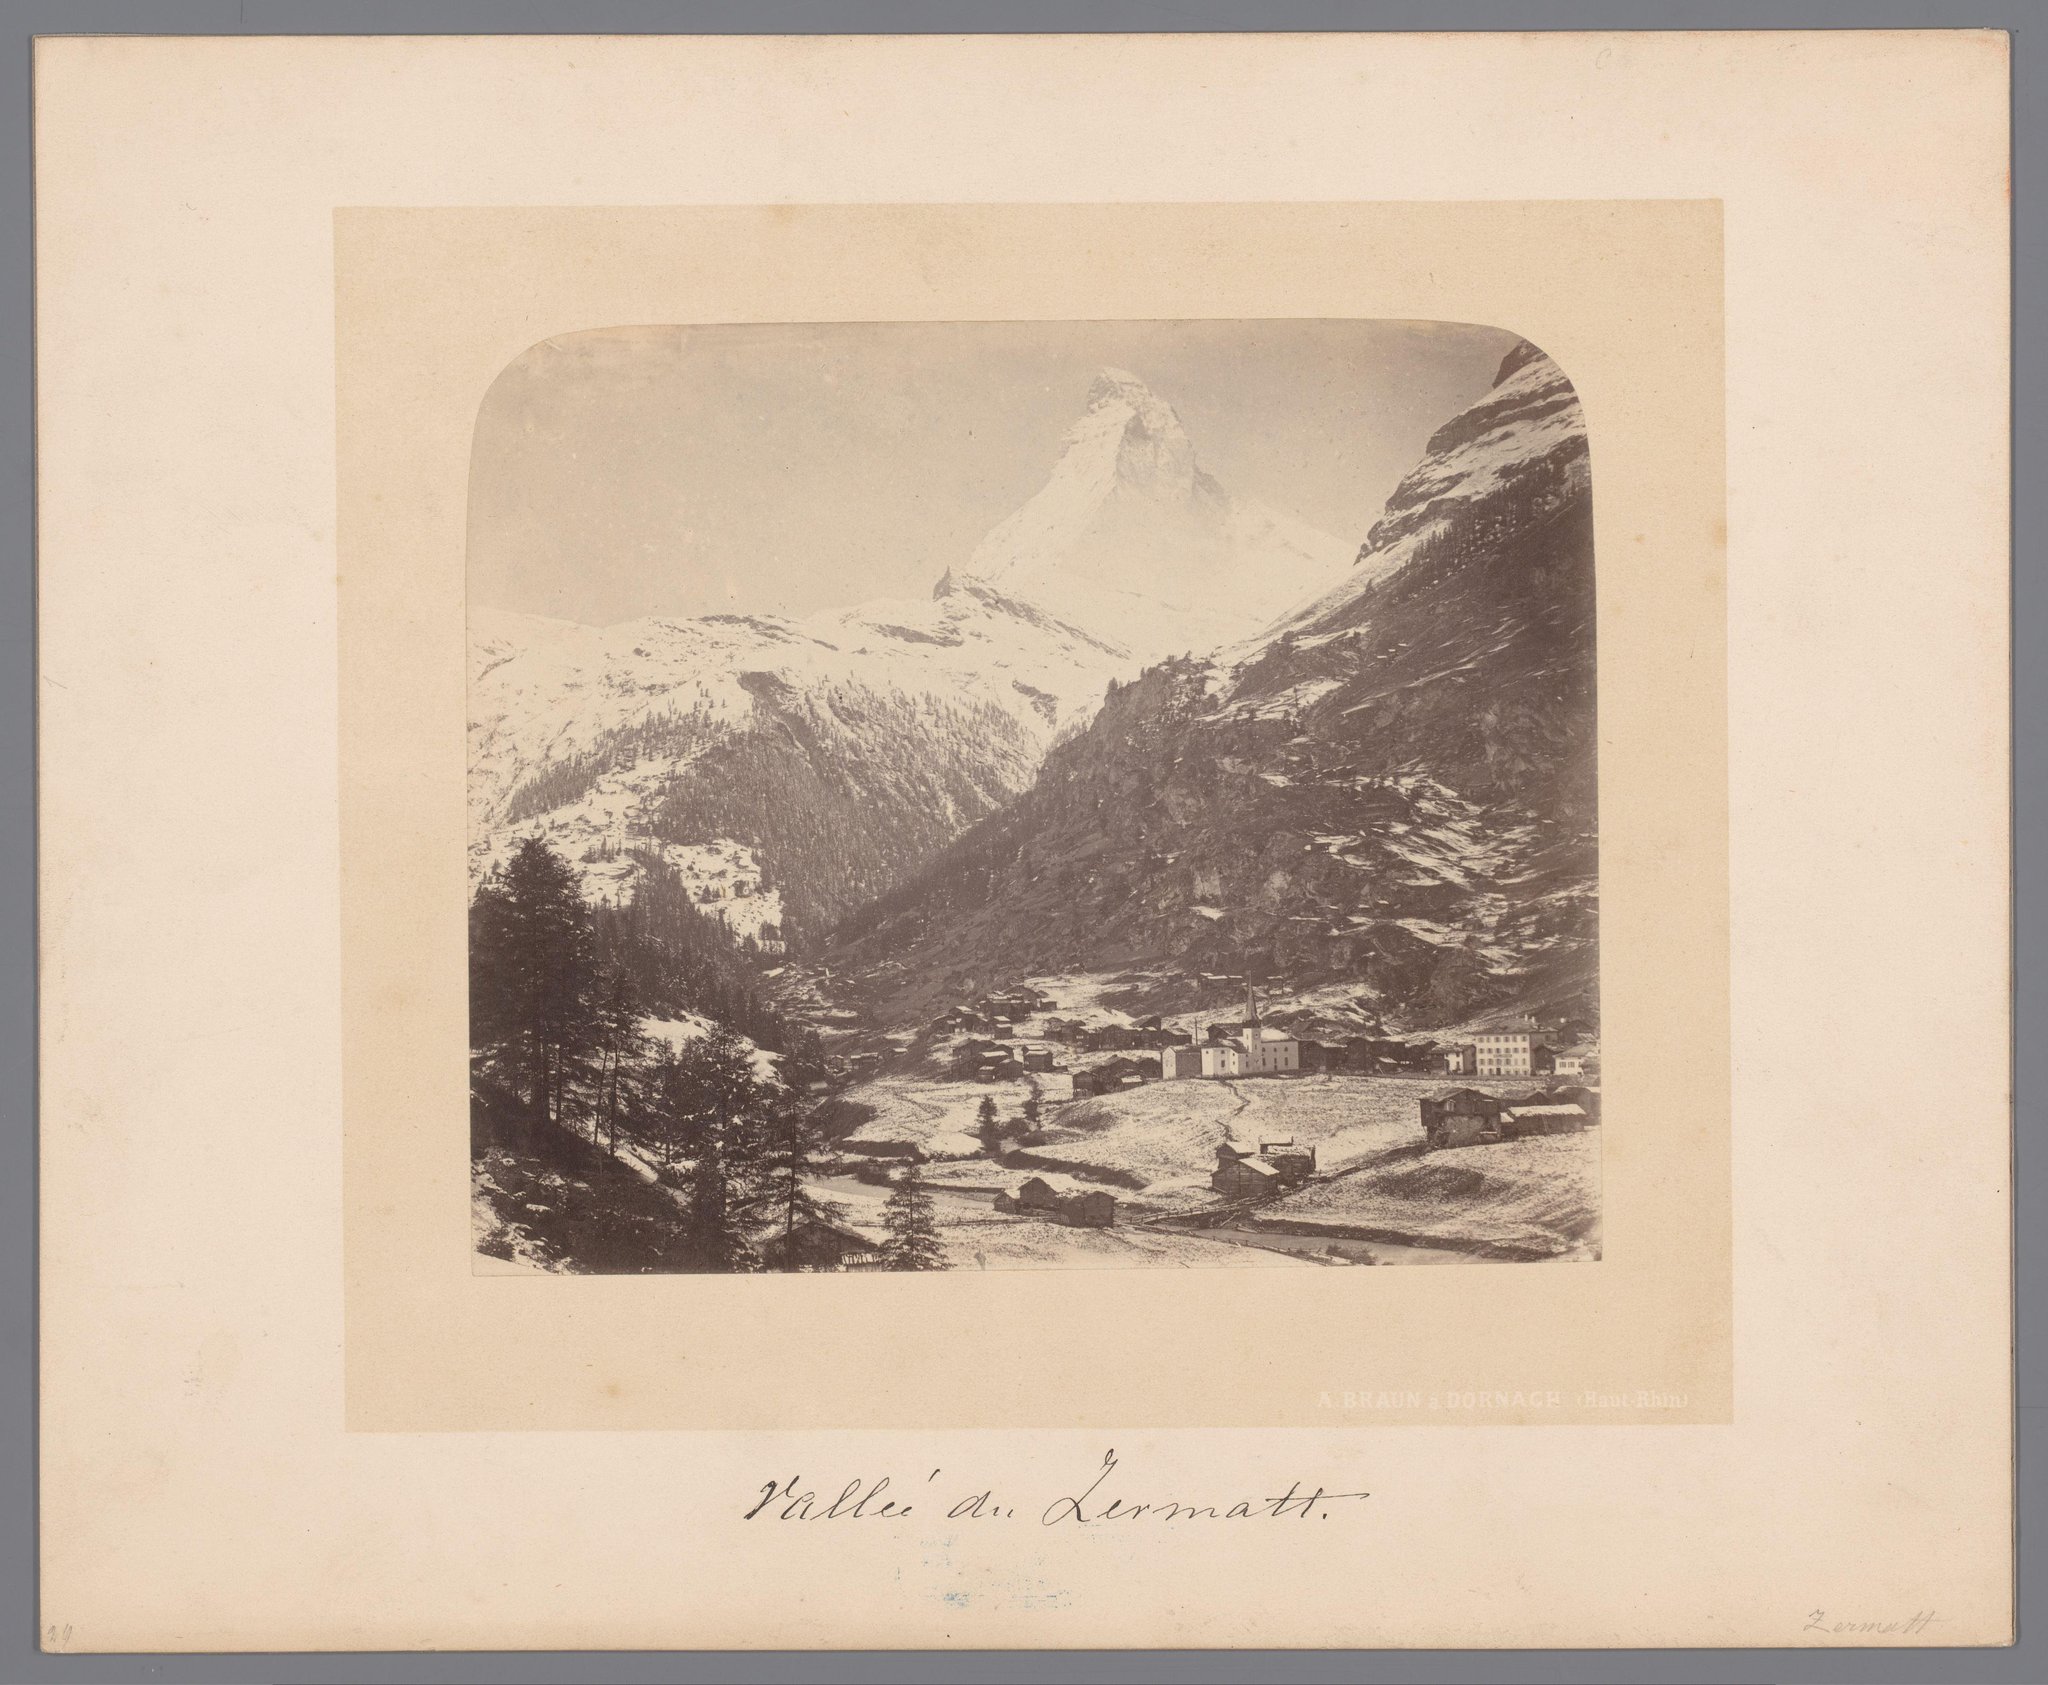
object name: photograph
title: Vallei van Zermatt, Zwitserland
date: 1860-1880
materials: cardboard, photographic support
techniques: albumen print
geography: france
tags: zermatt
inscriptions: inscription: ‘Zermatt’, number: ‘1091’, inscription: ‘A. Braun à Dornach (Haut-Rhin)’, inscription: ‘$ 100’, inscription: ‘Adolf [sic] Braun 1860's ƒ250//probably printed 1870's’, caption: ‘Vallée du Zermatt.’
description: Zermatt is een dorp en gemeente aan de voet van de Matterhorn in het Duits-sprekende deel van het kanton Wallis in het zuiden van Zwitserland. Op deze foto is de vallei te zien met de besneeuwde Matterhorn op de achtergrond.